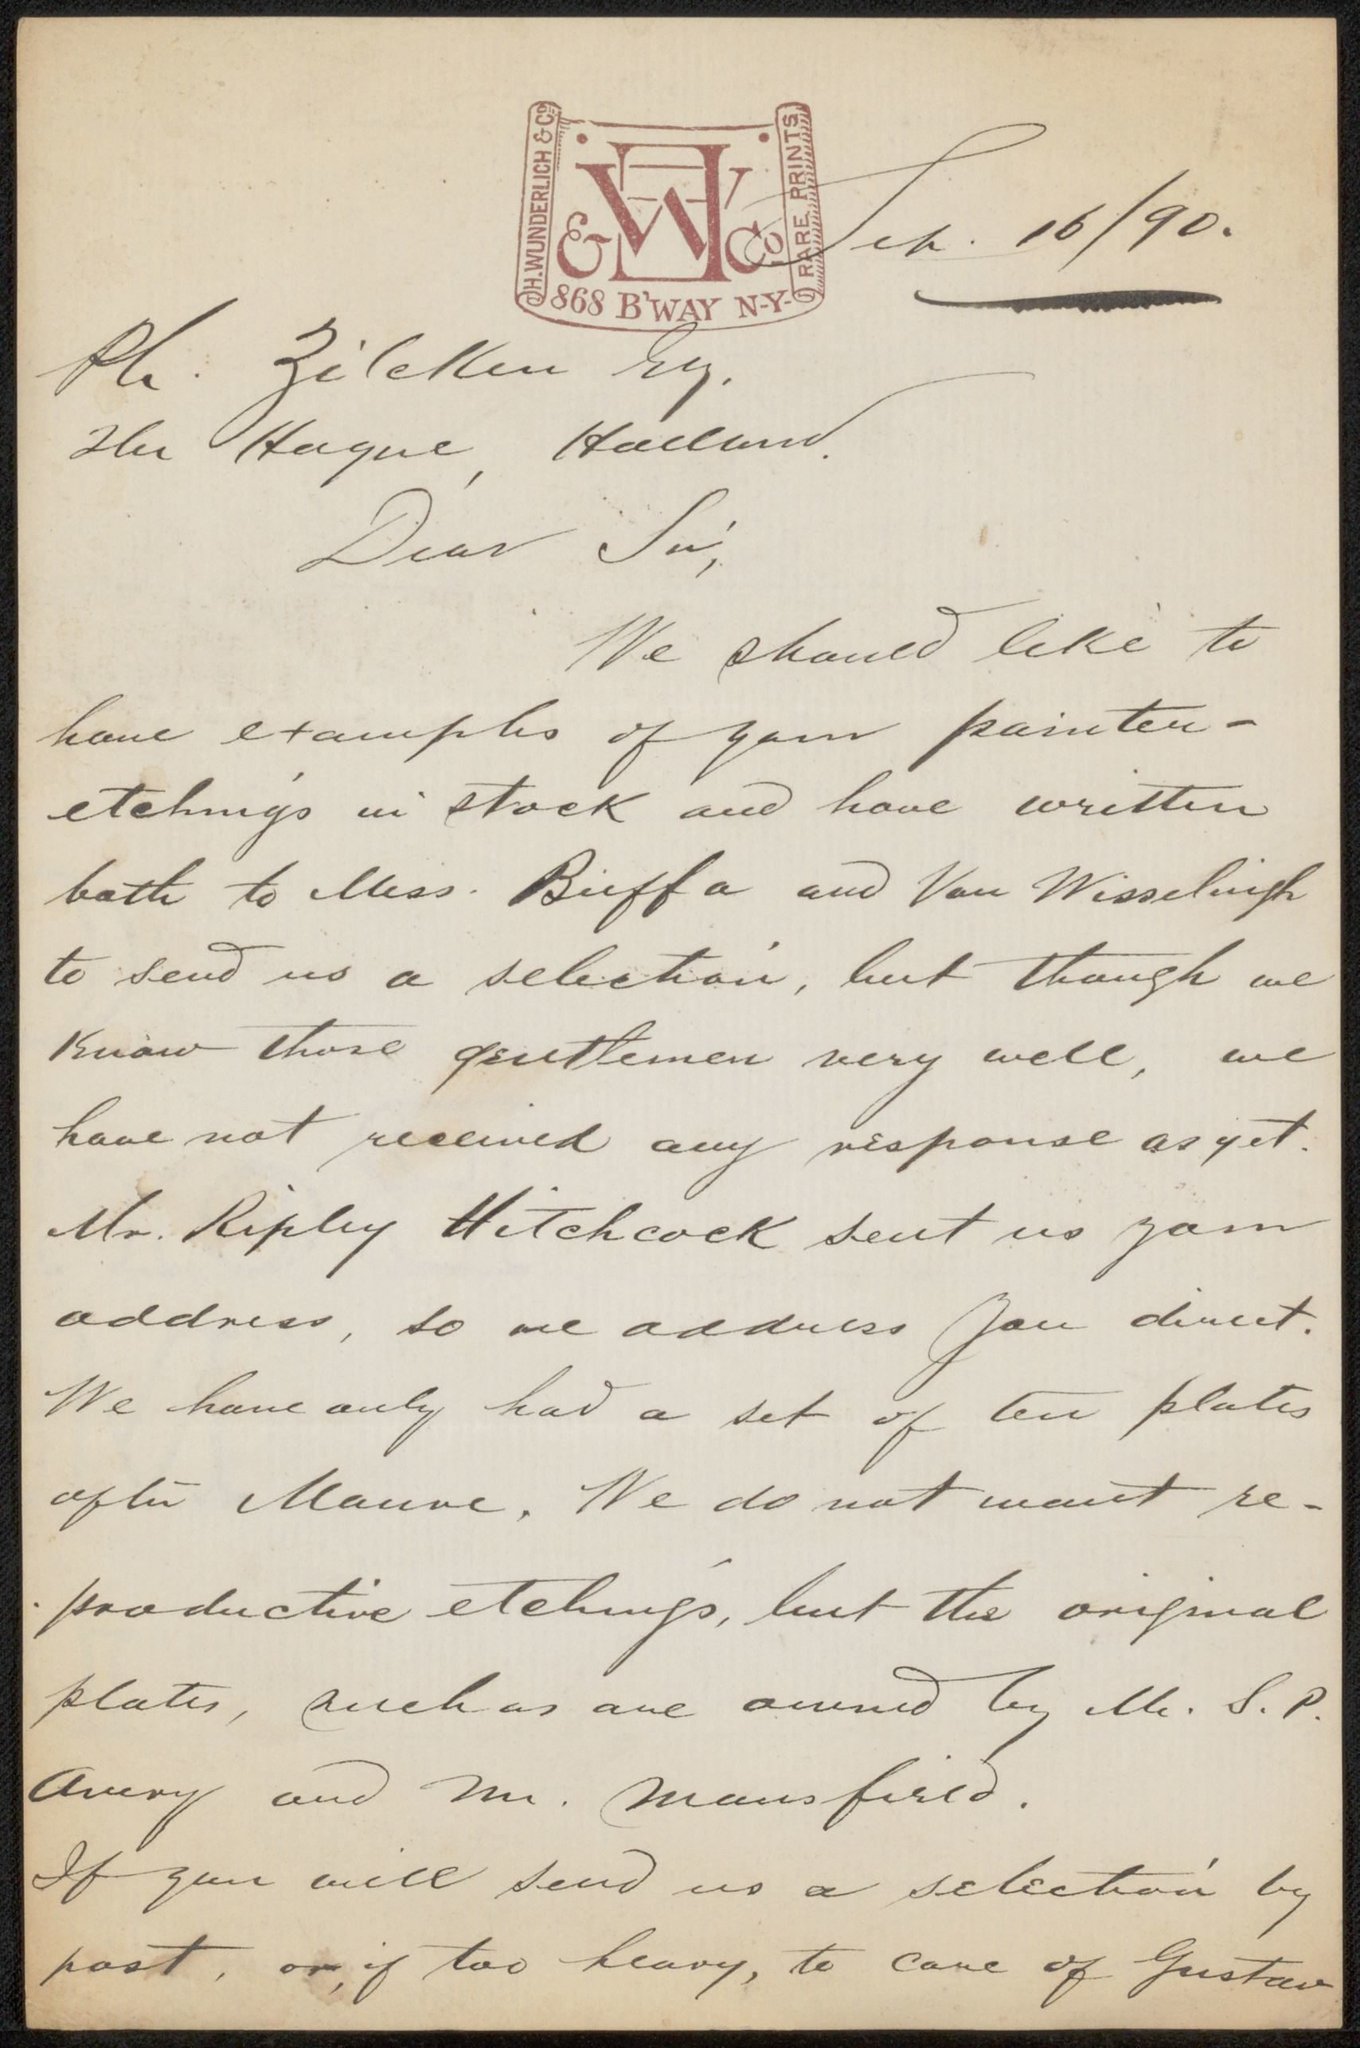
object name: letter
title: Brief aan Philip Zilcken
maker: hermann wunderlich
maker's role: kunsthandelaar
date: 1890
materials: ink, paper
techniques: pen, printing, writing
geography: new york city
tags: arnhem, painter, print maker, draughtsman, anton mauve, publisher, new york (city), samuel putnam avery, howard mansfield, the hague, philip zilcken, the graphic arts, money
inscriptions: watermark